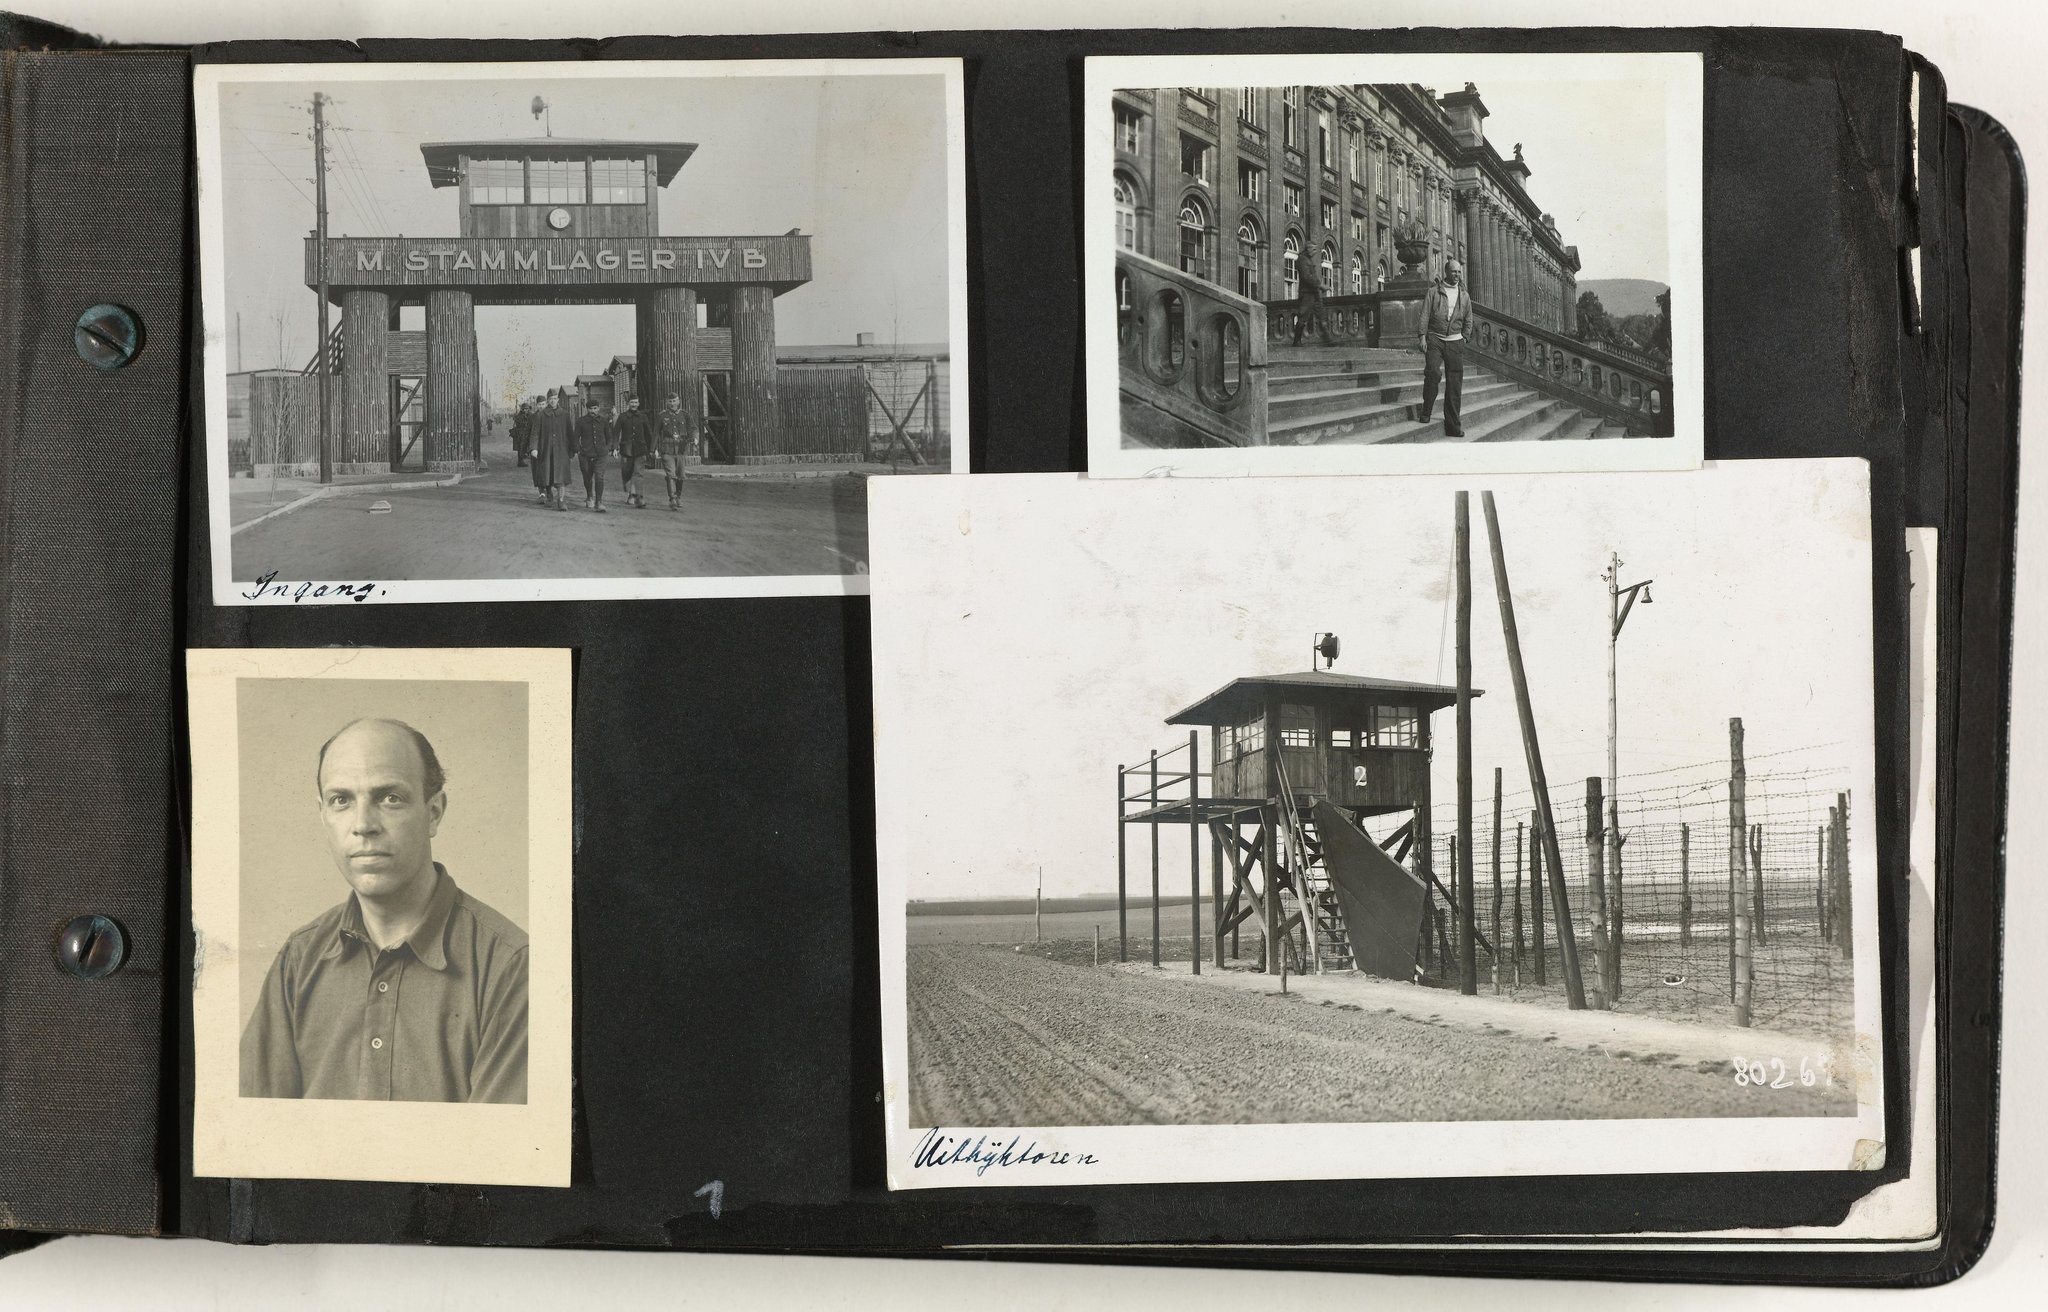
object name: album leaf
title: Krijgsgevangenenkamp en portretten van Dick van Maarseveen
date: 1943-1945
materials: cardboard, photographic support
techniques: gelatin silver print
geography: muhlberg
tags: the hague, dick w.b. van maarseveen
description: Albumblad met vier foto's: portret van Dick van Maarseveen, een wachttoren van het kamp, de ingang en Van Maarseveen op de trappen van een groot gebouw. Onderdeel van een fotoalbum met foto's door Dick van Maarseveen van het krijgsgevangenenkamp Stalag IV B in Mühlberg in de periode 1943-1945.